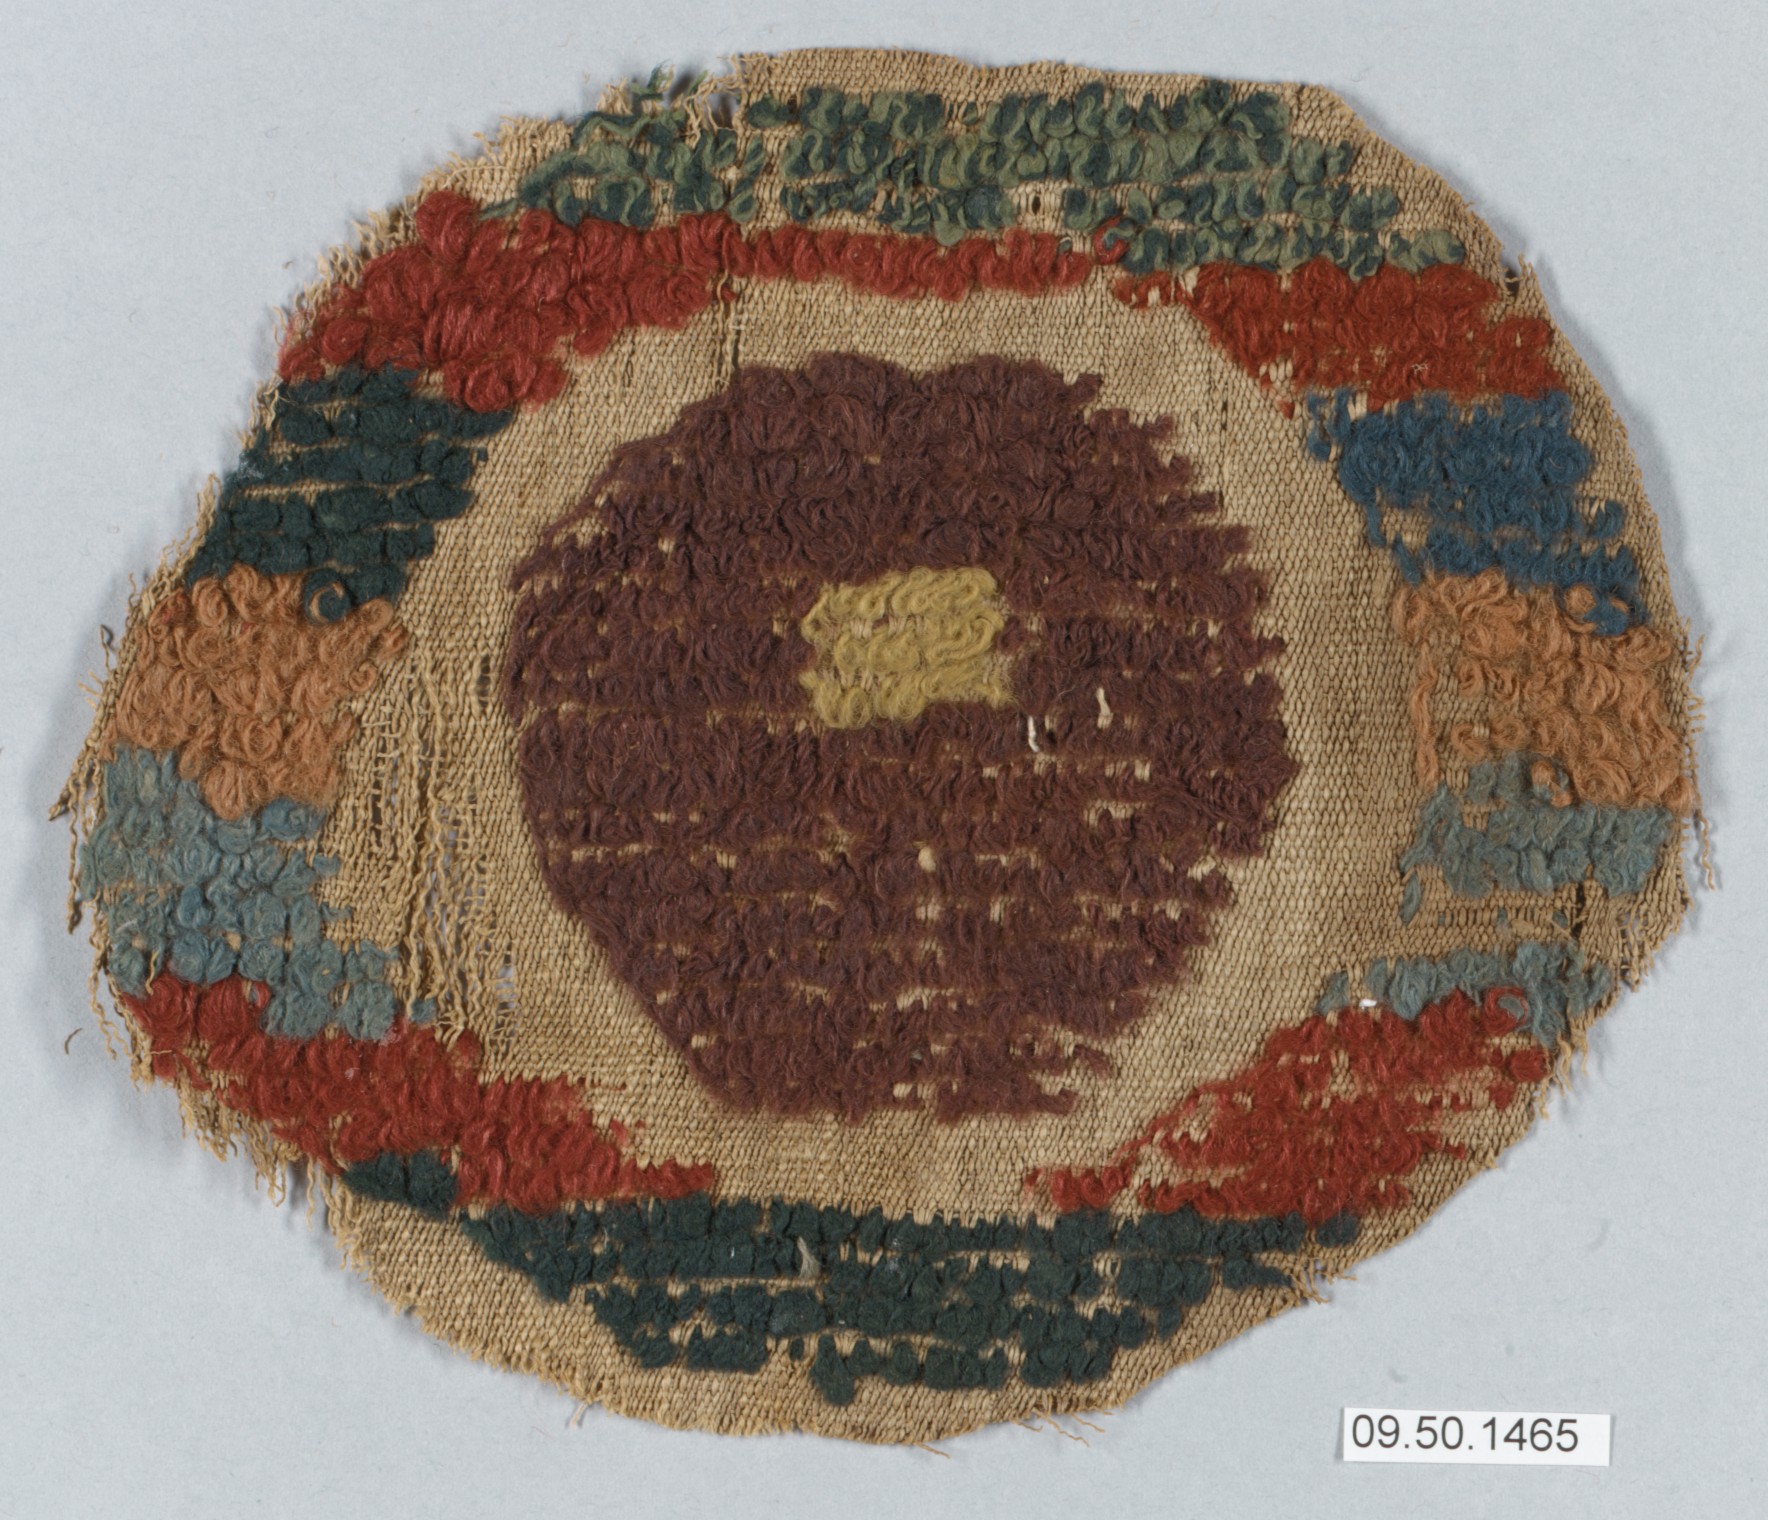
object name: roundel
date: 201-400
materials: linen, wool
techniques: embroidery, weave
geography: egypt